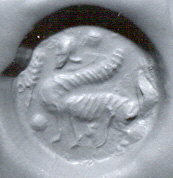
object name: stamp seal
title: Stamp seal (scaraboid) with monster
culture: assyrian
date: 734-601 BCE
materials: marble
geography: urartu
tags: sphinx